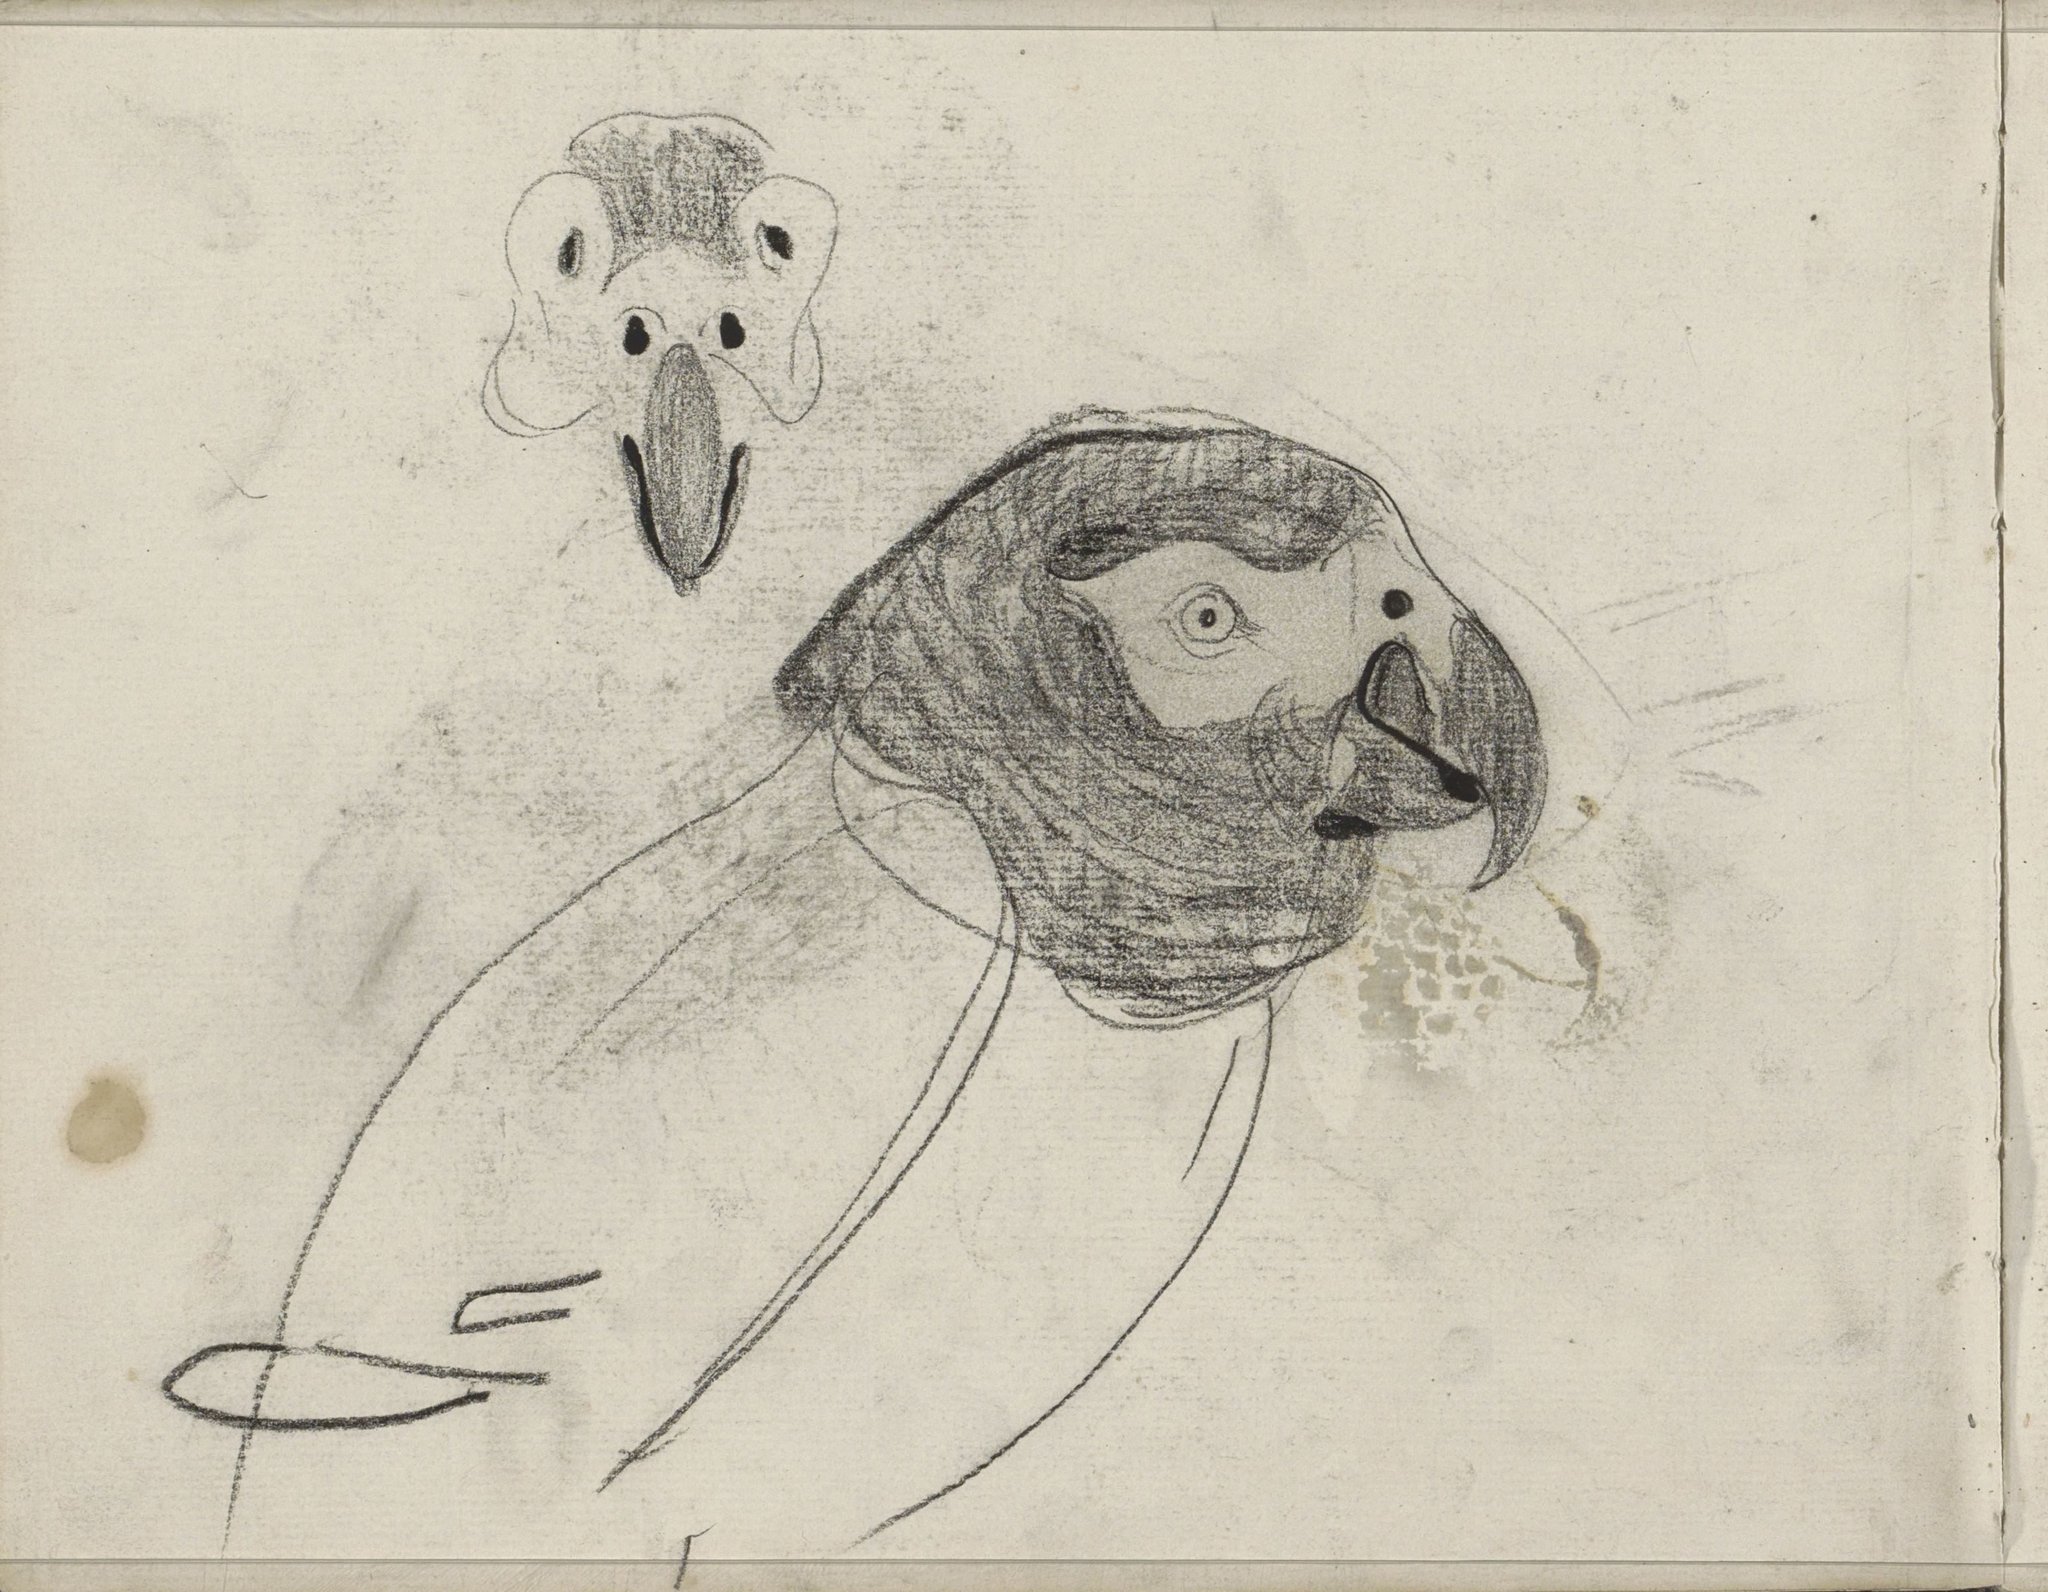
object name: sketchbook leaf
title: Papegaai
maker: carel adolph lion cachet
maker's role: draughtsman, print maker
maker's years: 1864-1945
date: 1896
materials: chalk, paper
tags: ornamental birds: parrot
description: Tevens een kop van een papegaai. Blad 2 verso uit een schetsboek met 44 bladen.